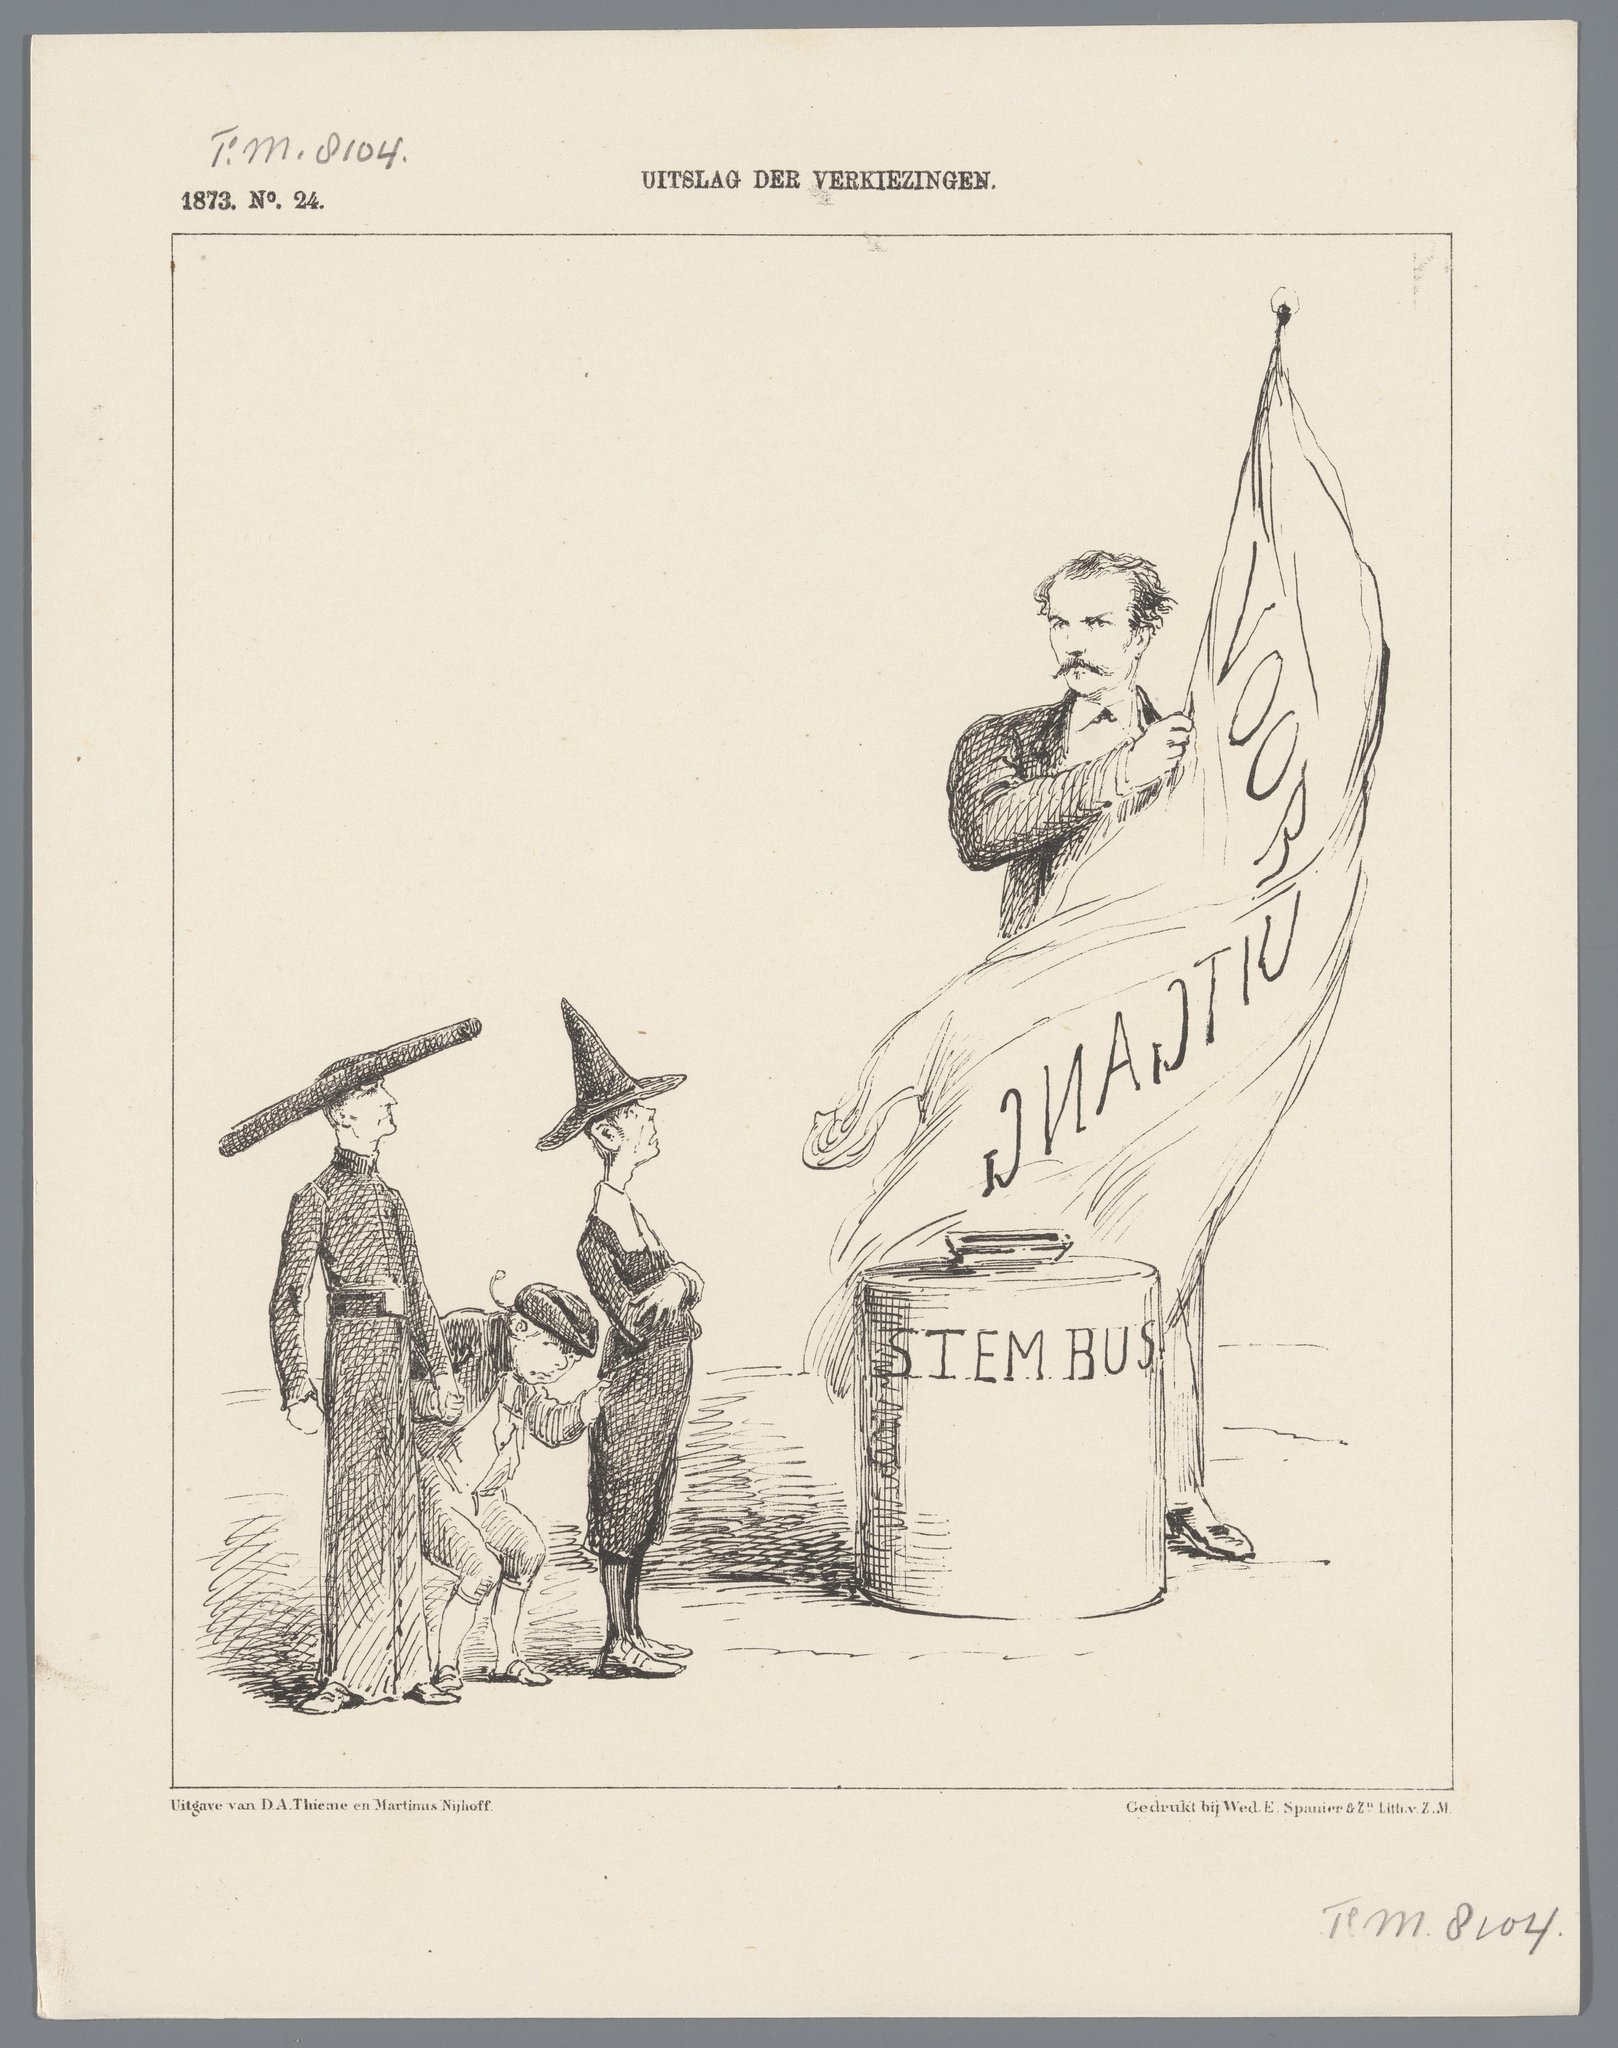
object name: cartoon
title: Uitslag der verkiezingen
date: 1873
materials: paper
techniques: lithograph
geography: netherlands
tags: voting, election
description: Spotprent op de uitslag van de tussentijdse verkiezingen van 1873, waarin de liberalen winst behaalden ten koste van de antirevolutionairen en conservatieven. Plaat verschenen bij het weekblad De Nederlandsche Spectator, nr. 24, 1873.